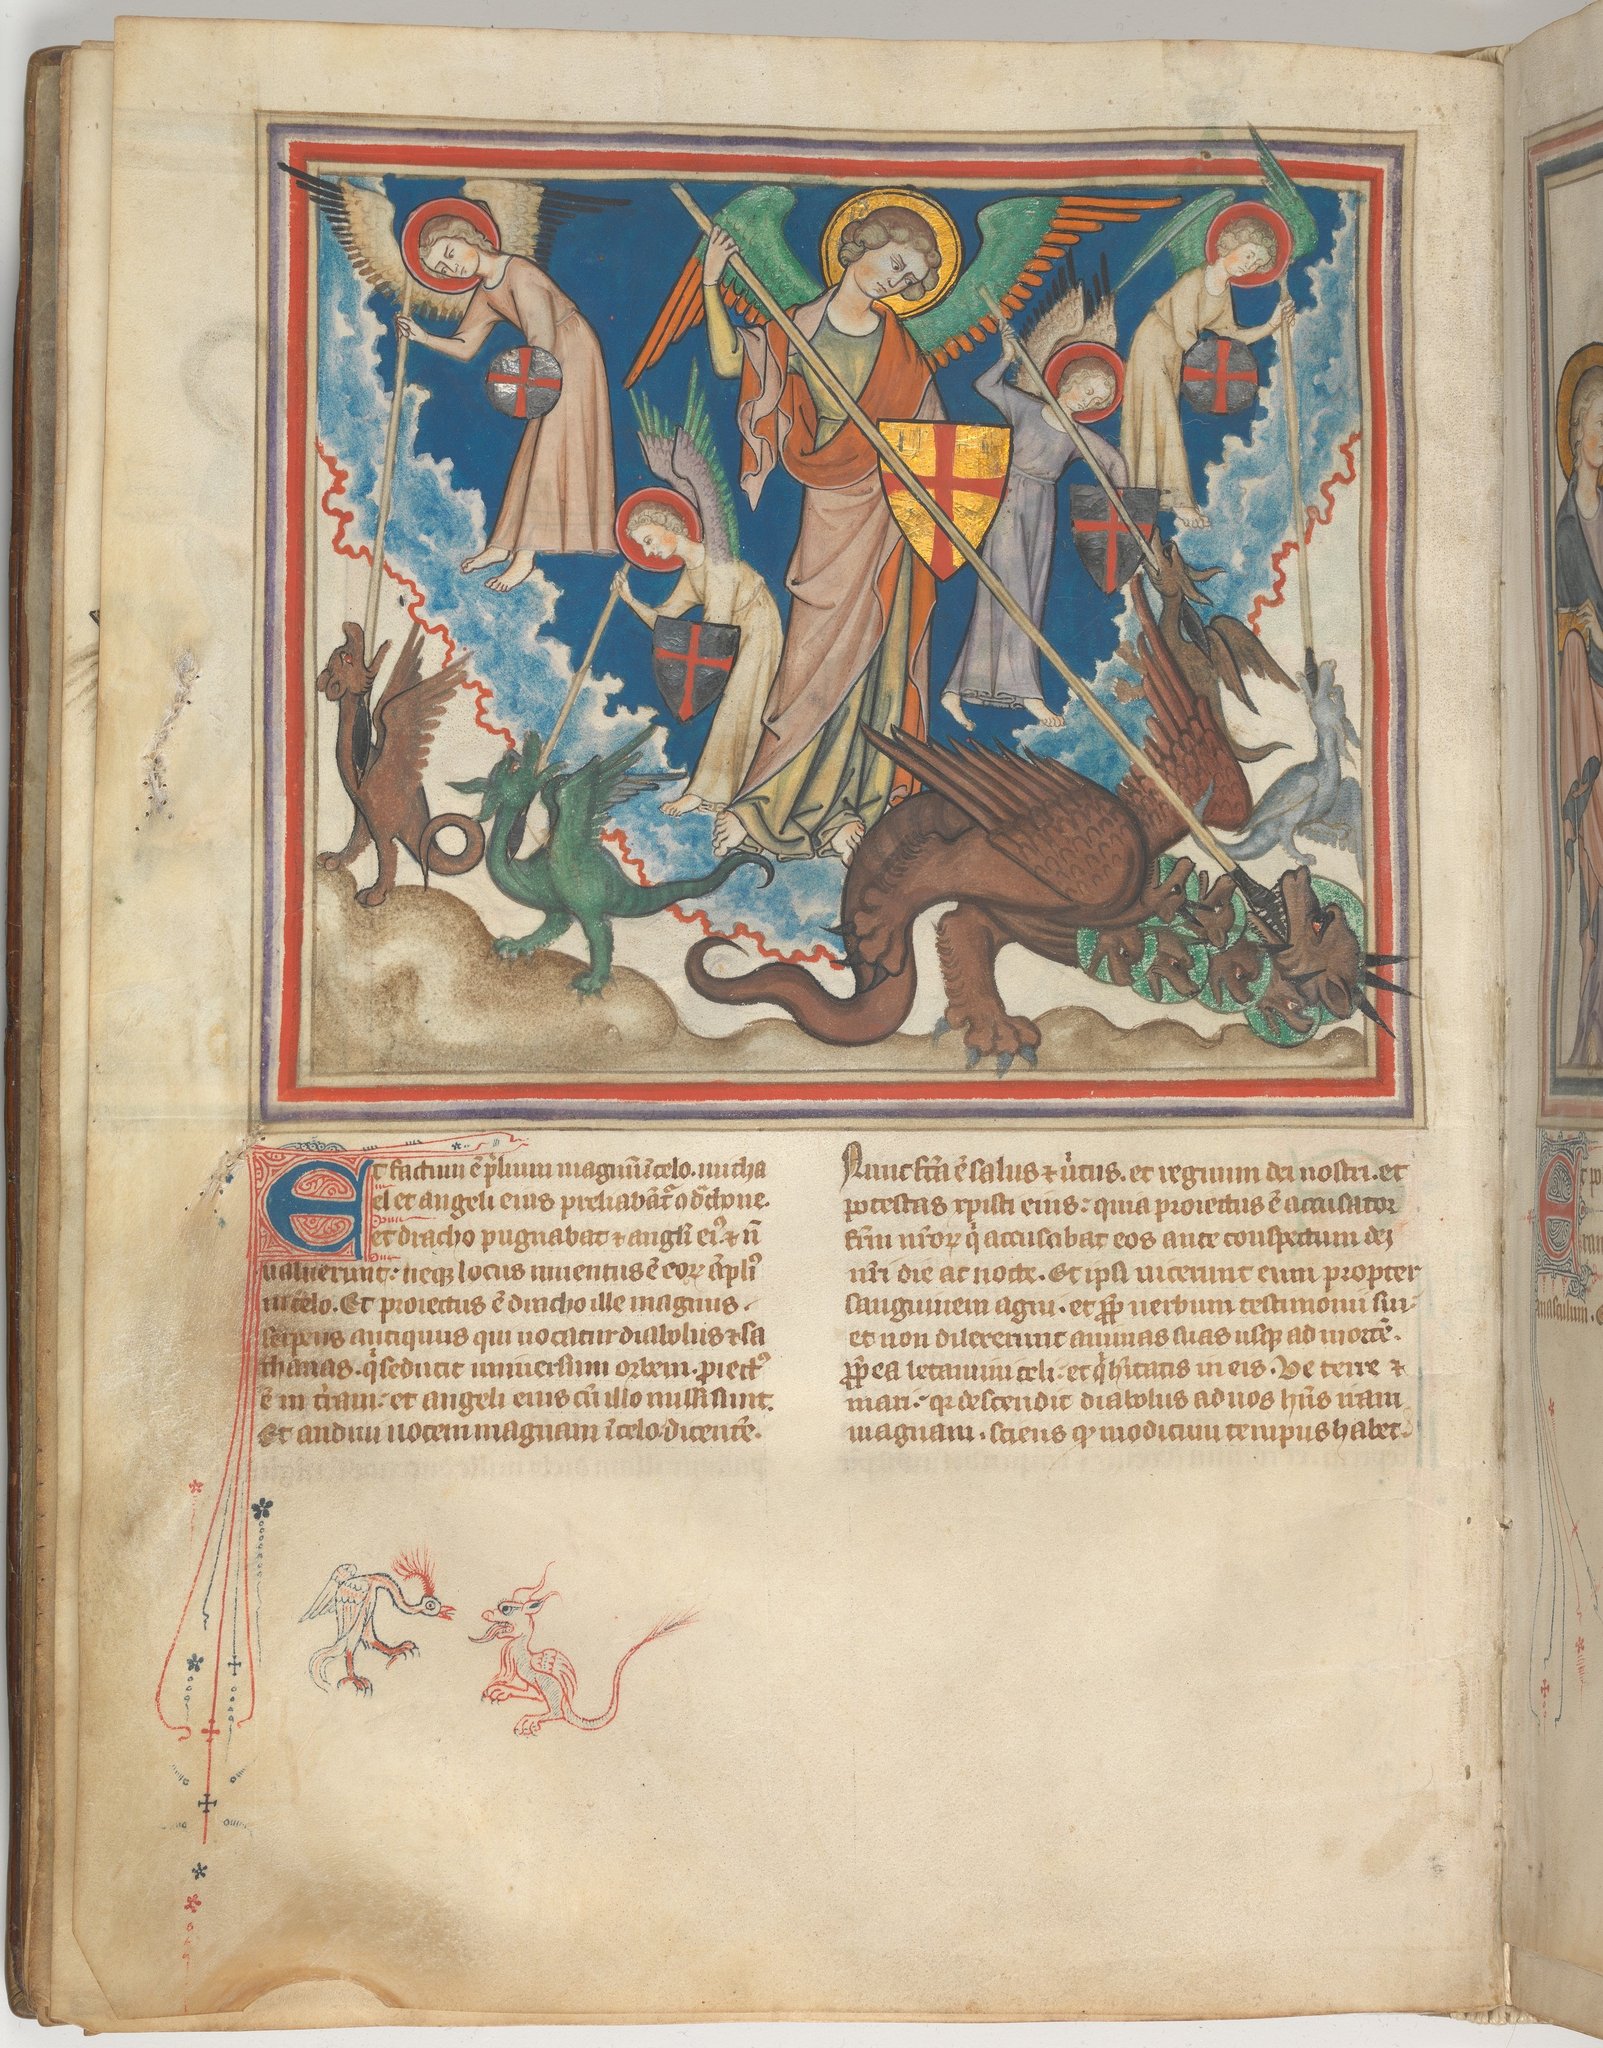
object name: apocalypse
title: The Cloisters Apocalypse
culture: french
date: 1330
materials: gold, ink, leather, parchment, silver, paint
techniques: bookbinding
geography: france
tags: angels,virgin mary,adoration of the magi,annunciation,apocalypse,visitation